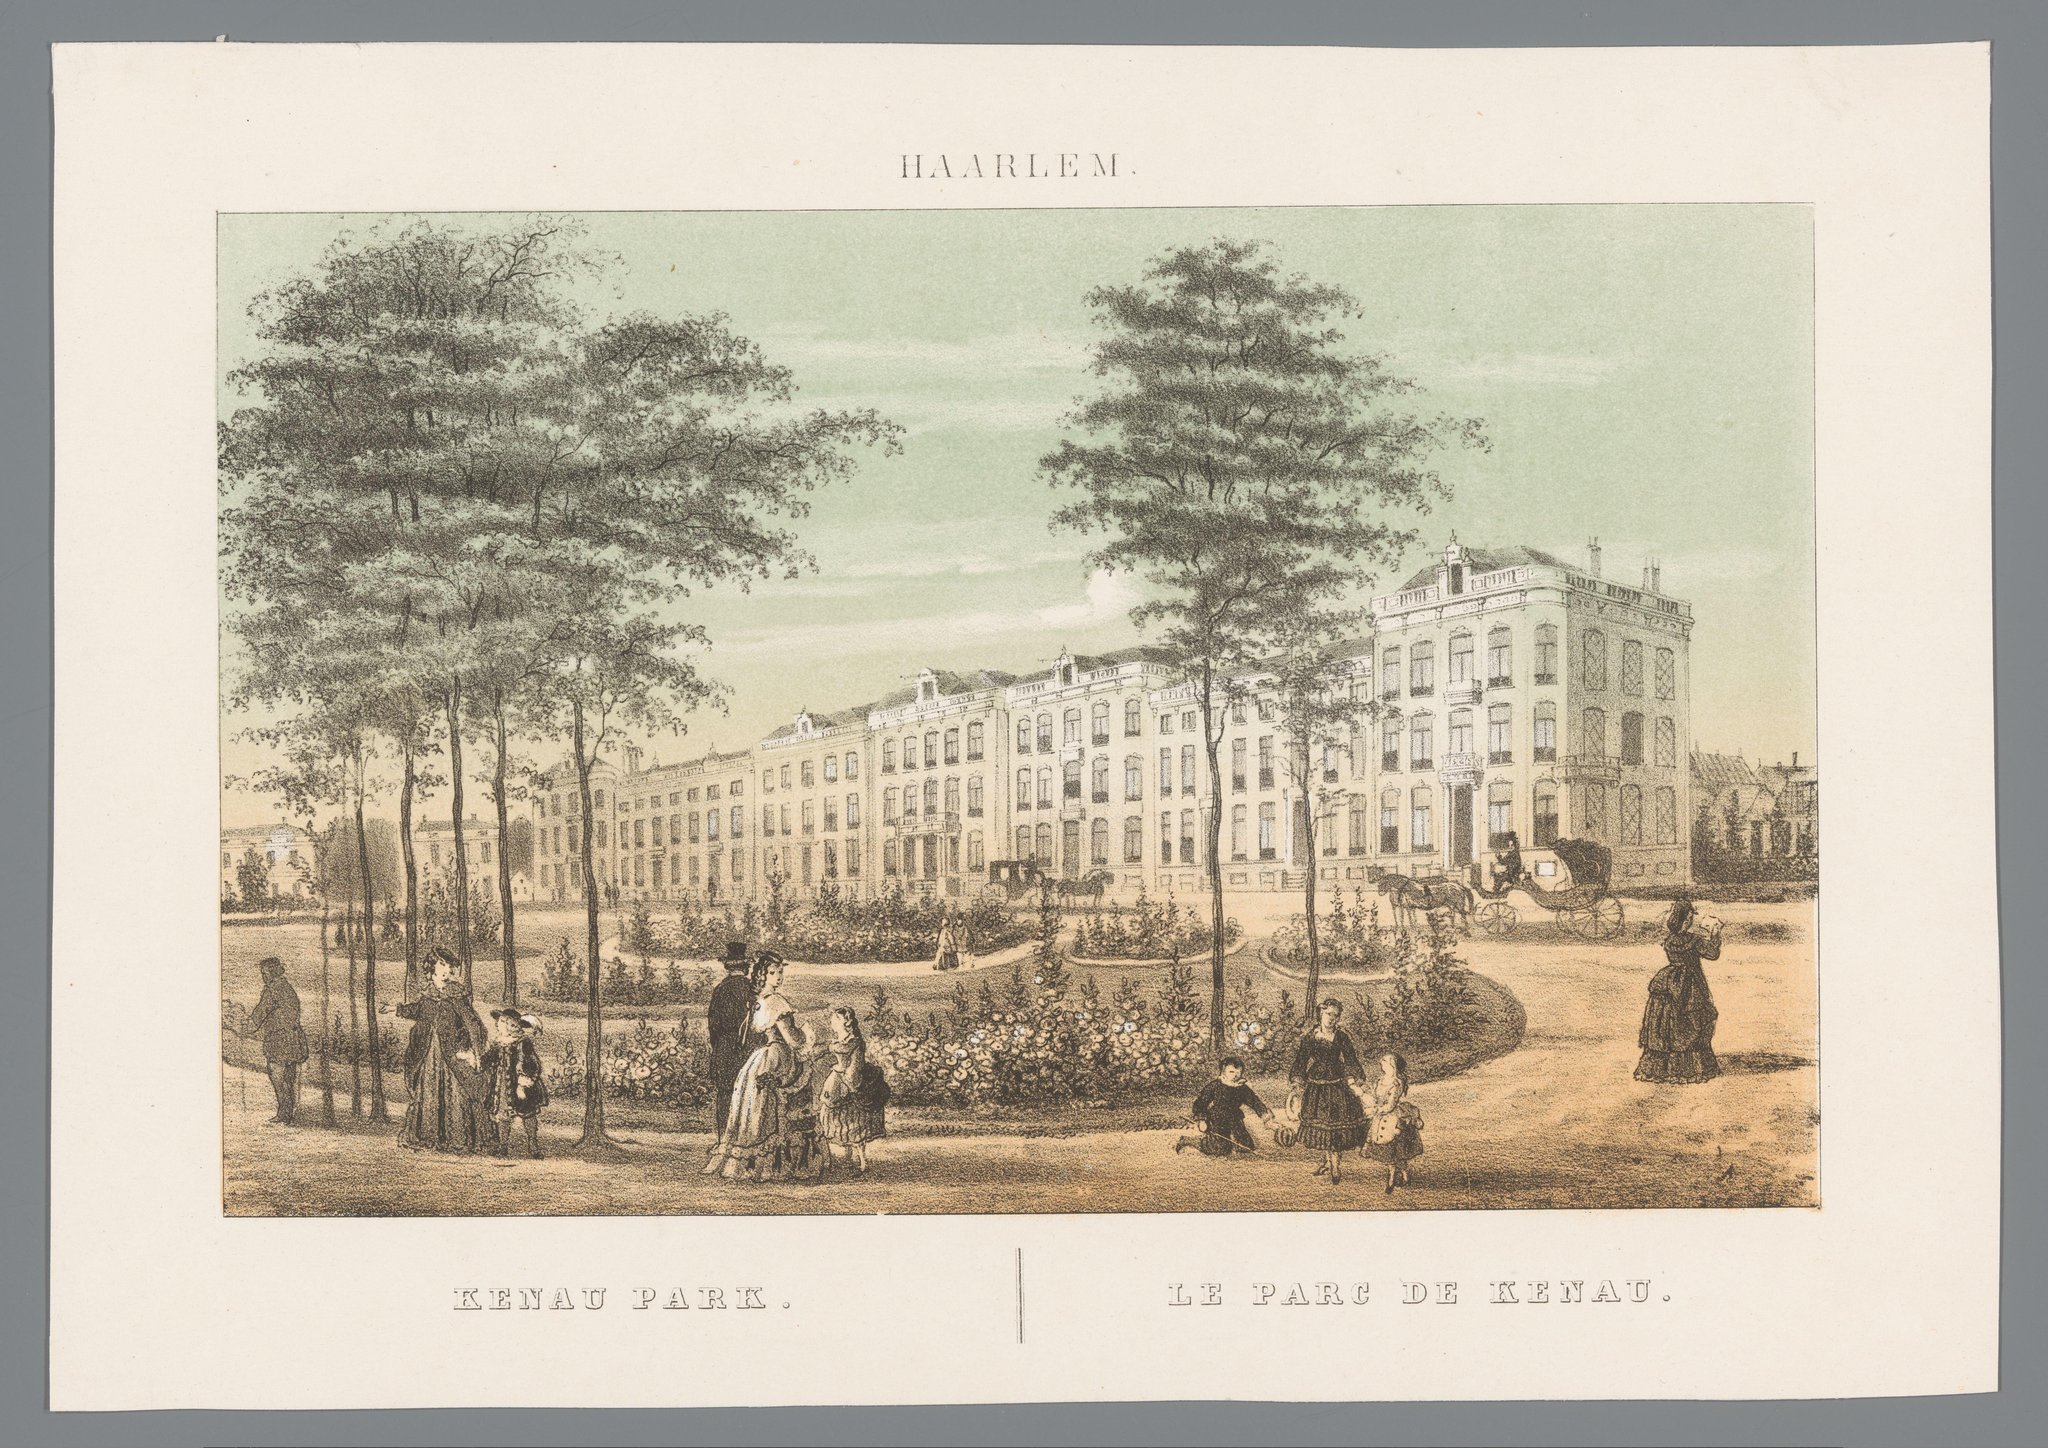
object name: print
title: Gezicht op het Kenaupark in Haarlem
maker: Anonymous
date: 1850-1900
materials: paper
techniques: tone lithography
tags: park, the usual house or row of houses, four-wheeled vehicle drawn by two animals, haarlem